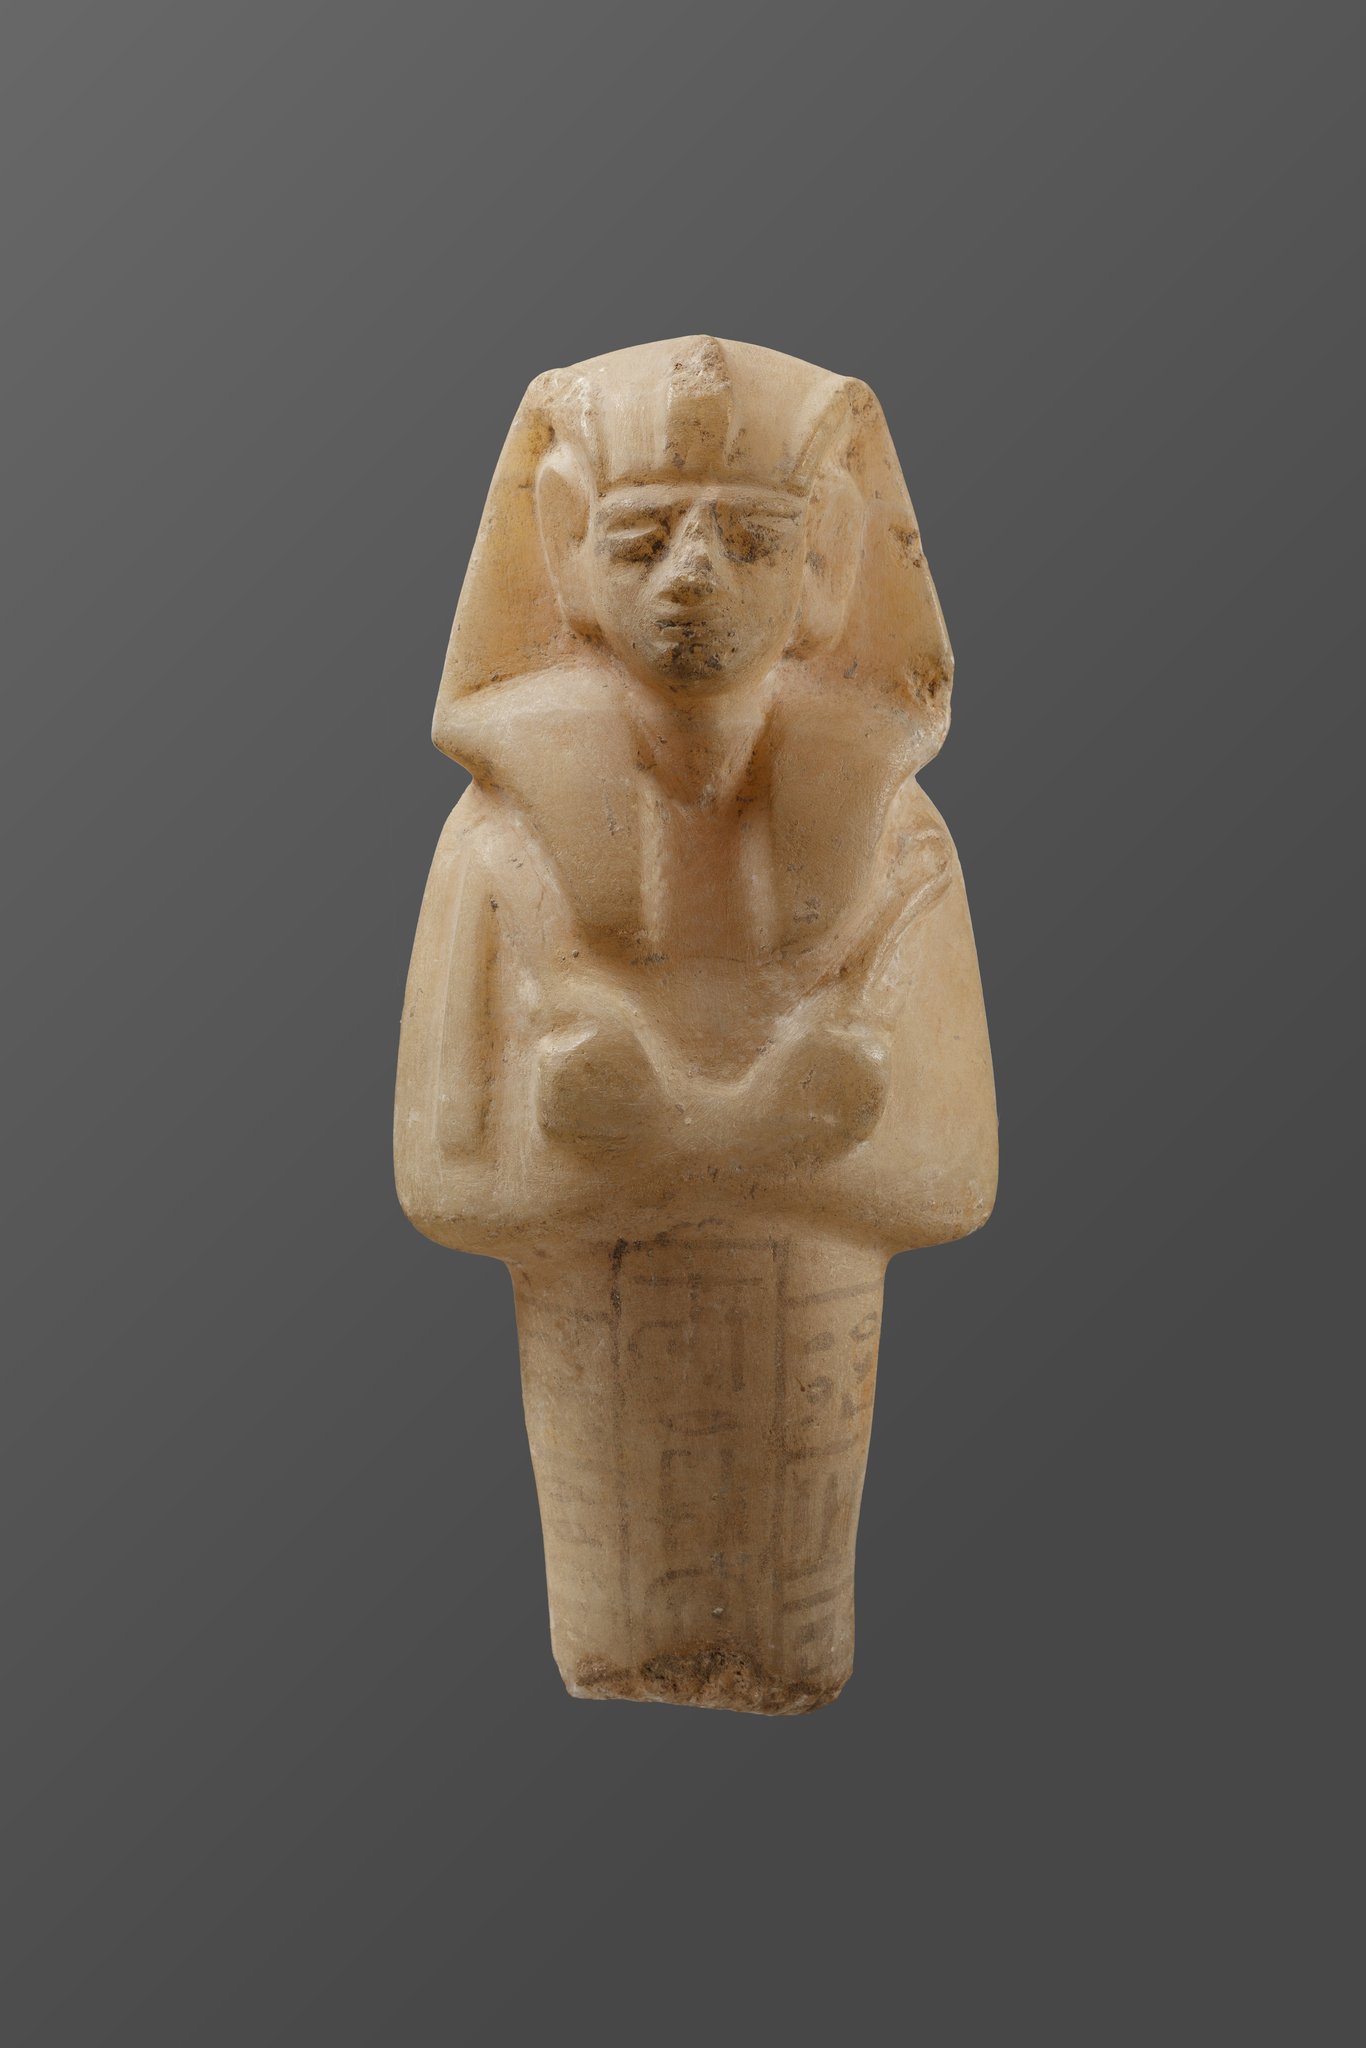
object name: shabti, siptah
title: Shabti of Siptah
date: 1194-1188 BCE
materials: stone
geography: egypt